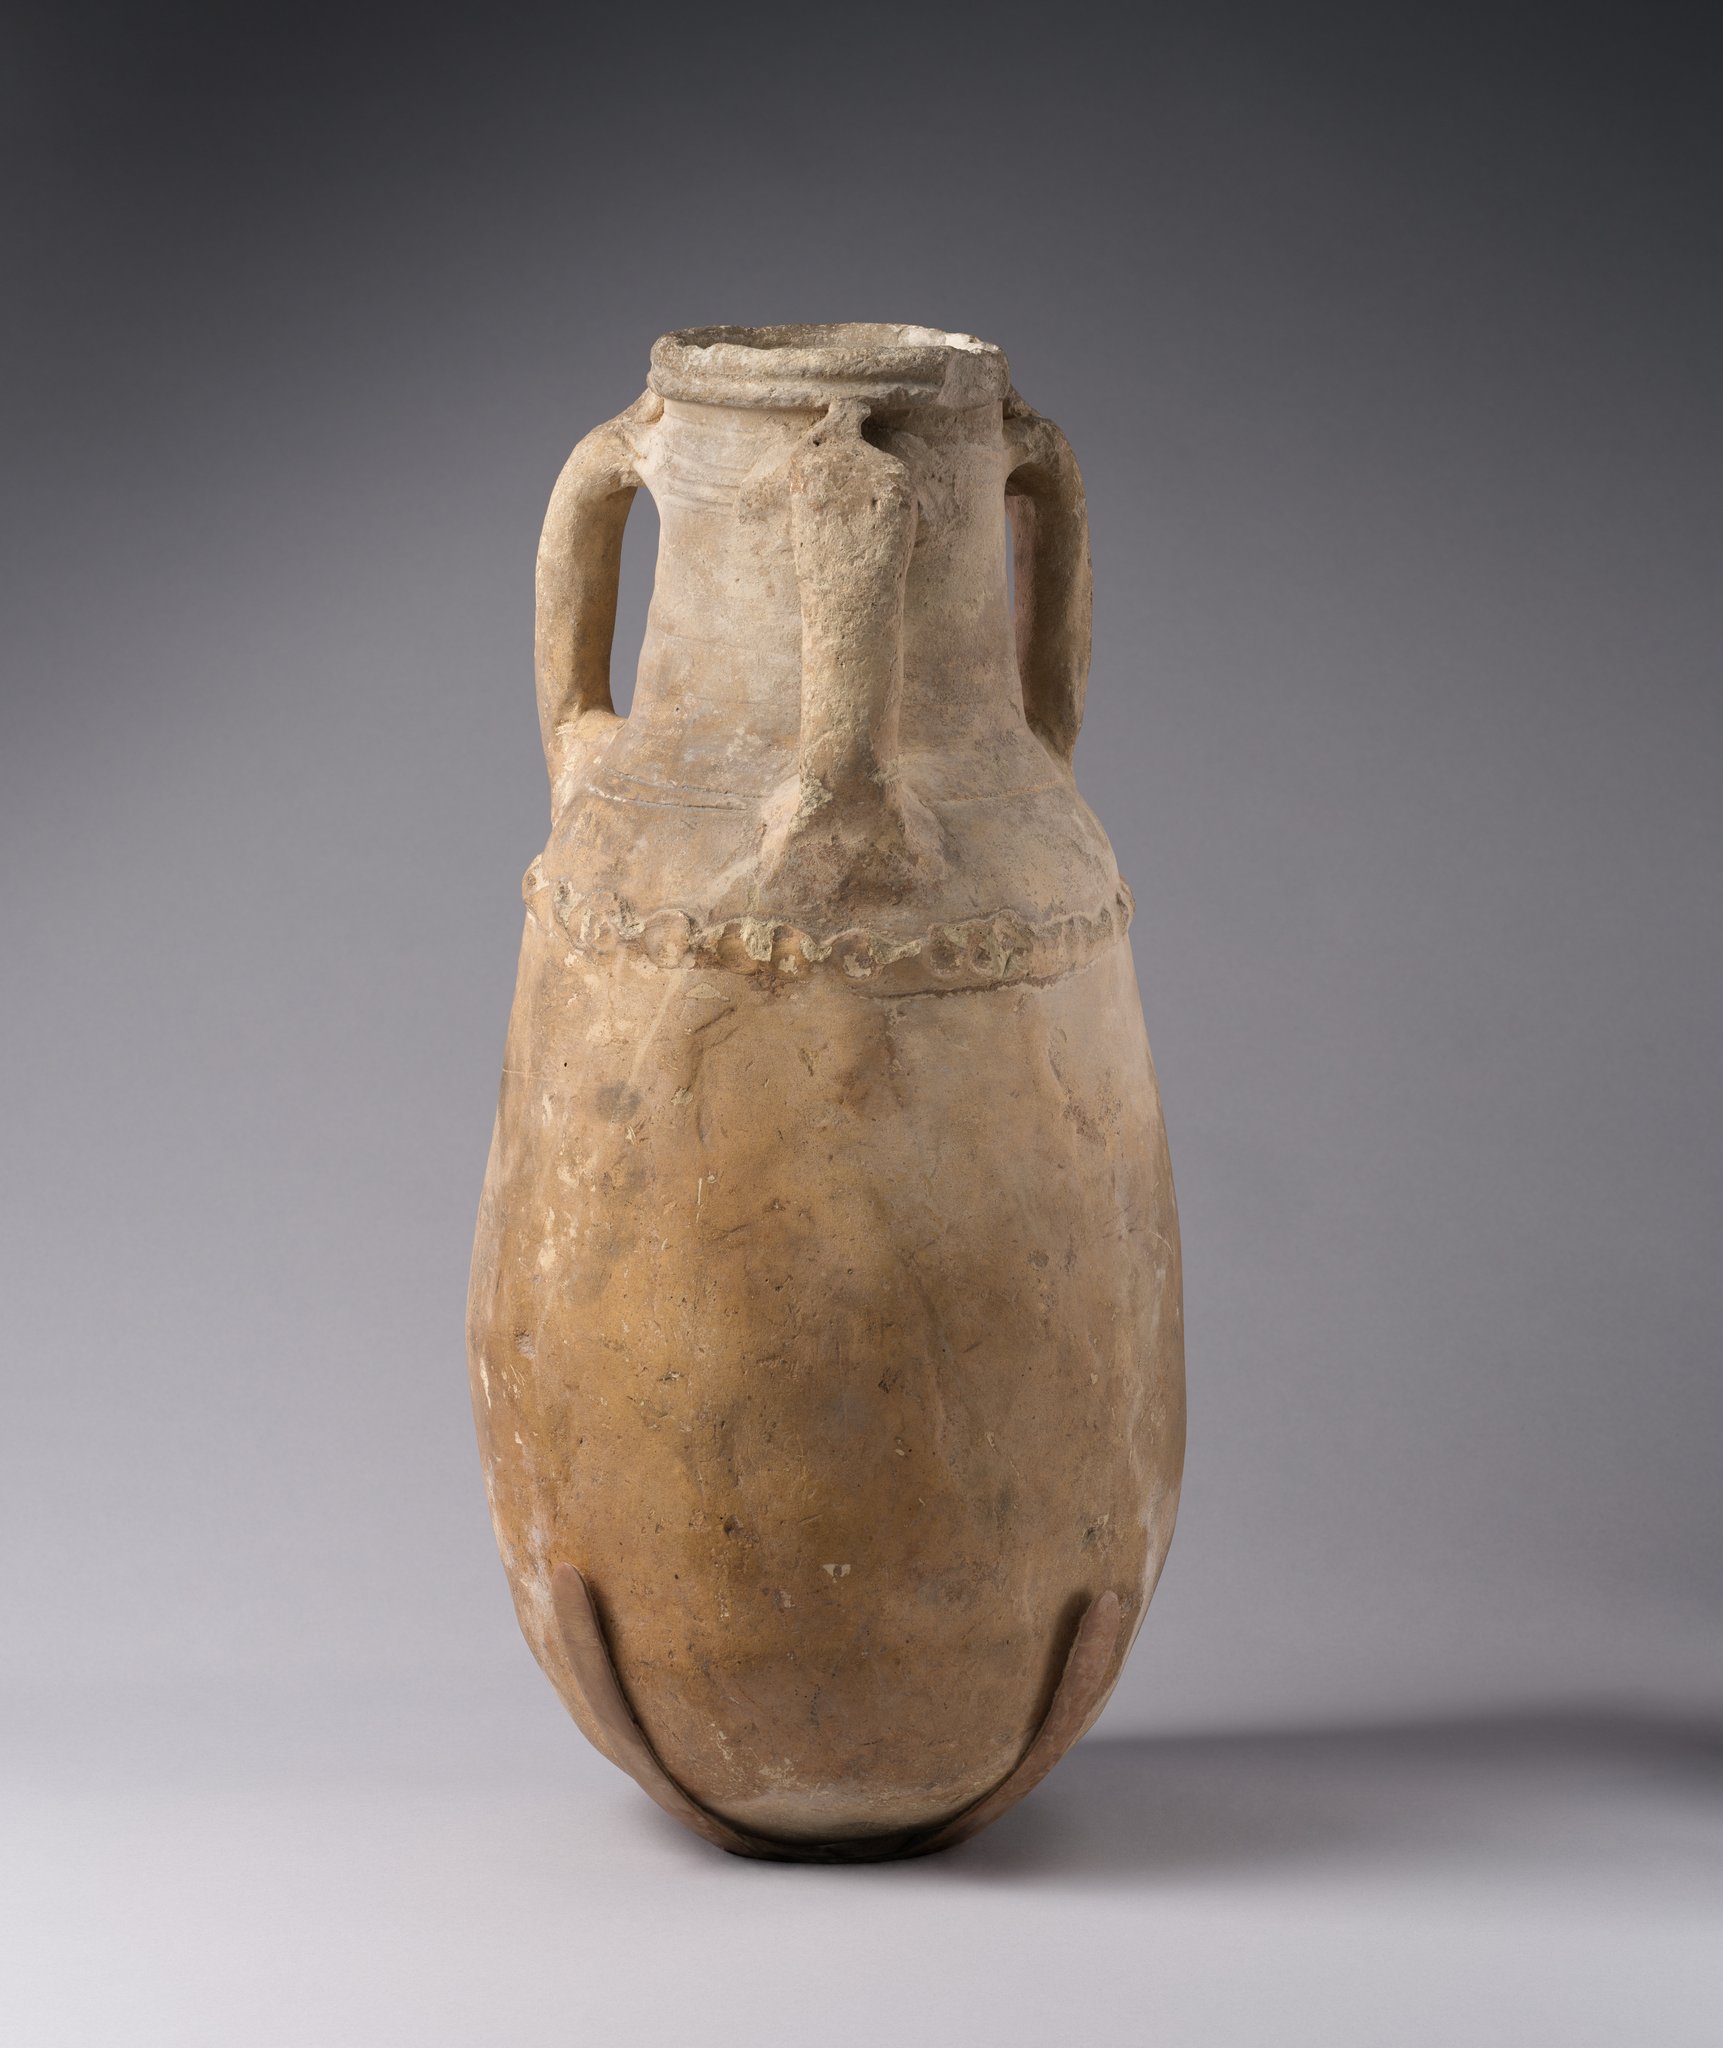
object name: jar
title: Storage jar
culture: parthian or sasanian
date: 201-700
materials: ceramic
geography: mesopotamia